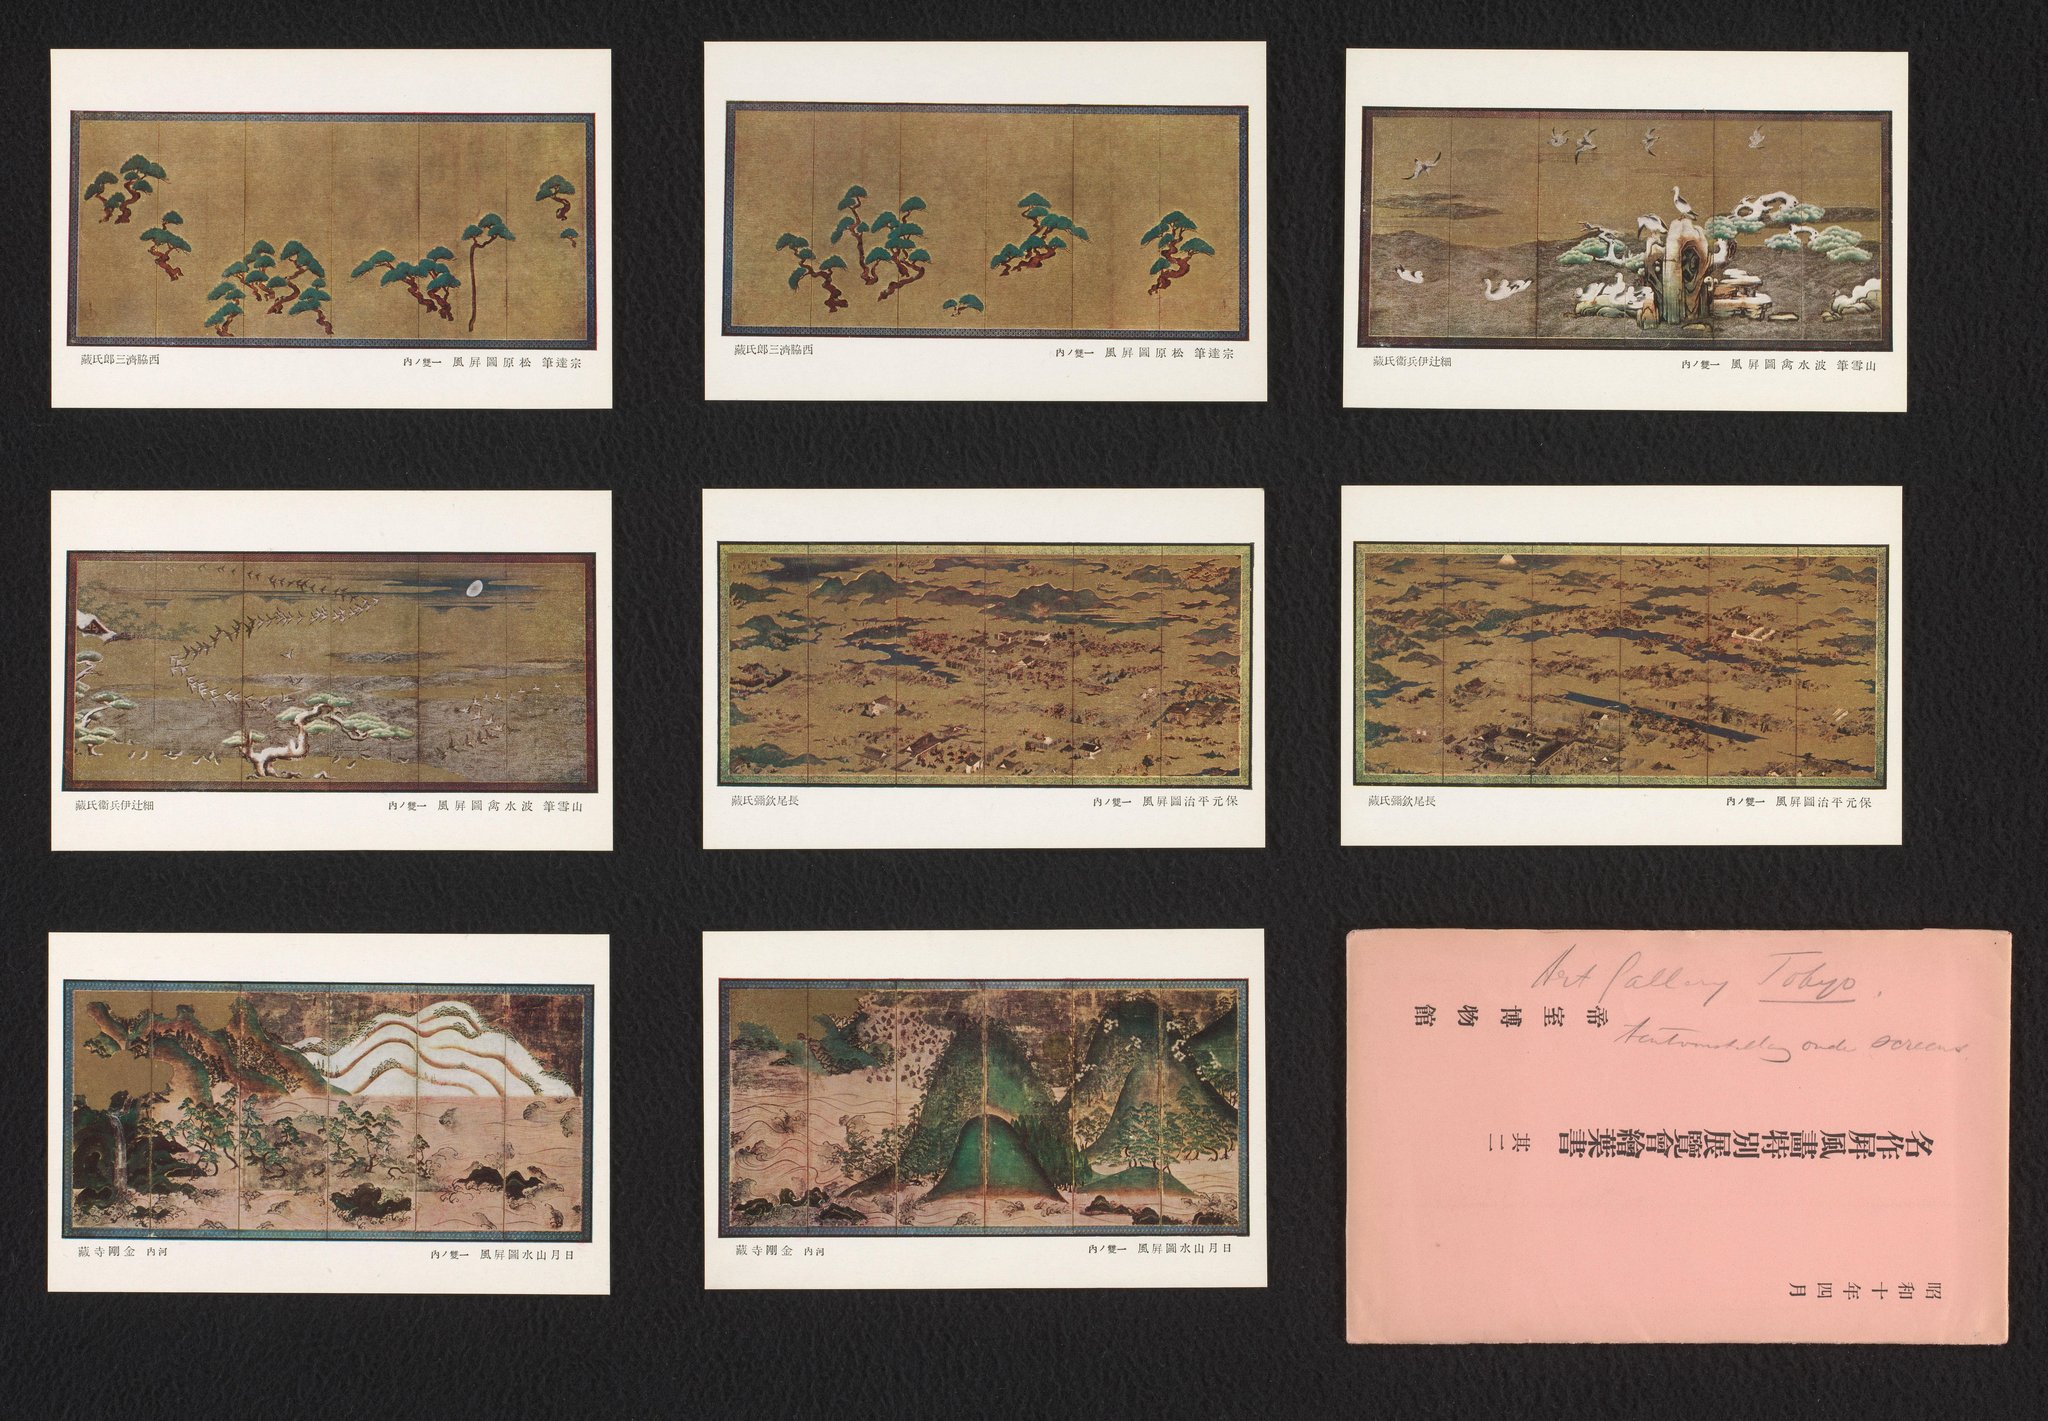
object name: photomechanical print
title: Prentbriefkaarten met ontwerpen voor kamerschermen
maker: Anonymous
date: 1925-1940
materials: paper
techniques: lithograph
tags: screen, folding screen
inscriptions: inscription: ‘Art Gallery Tokyo/ tentoonstelling oude screens’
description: Acht prentbriefkaarten met ontwerpen voor kamerschermen in een envelop.